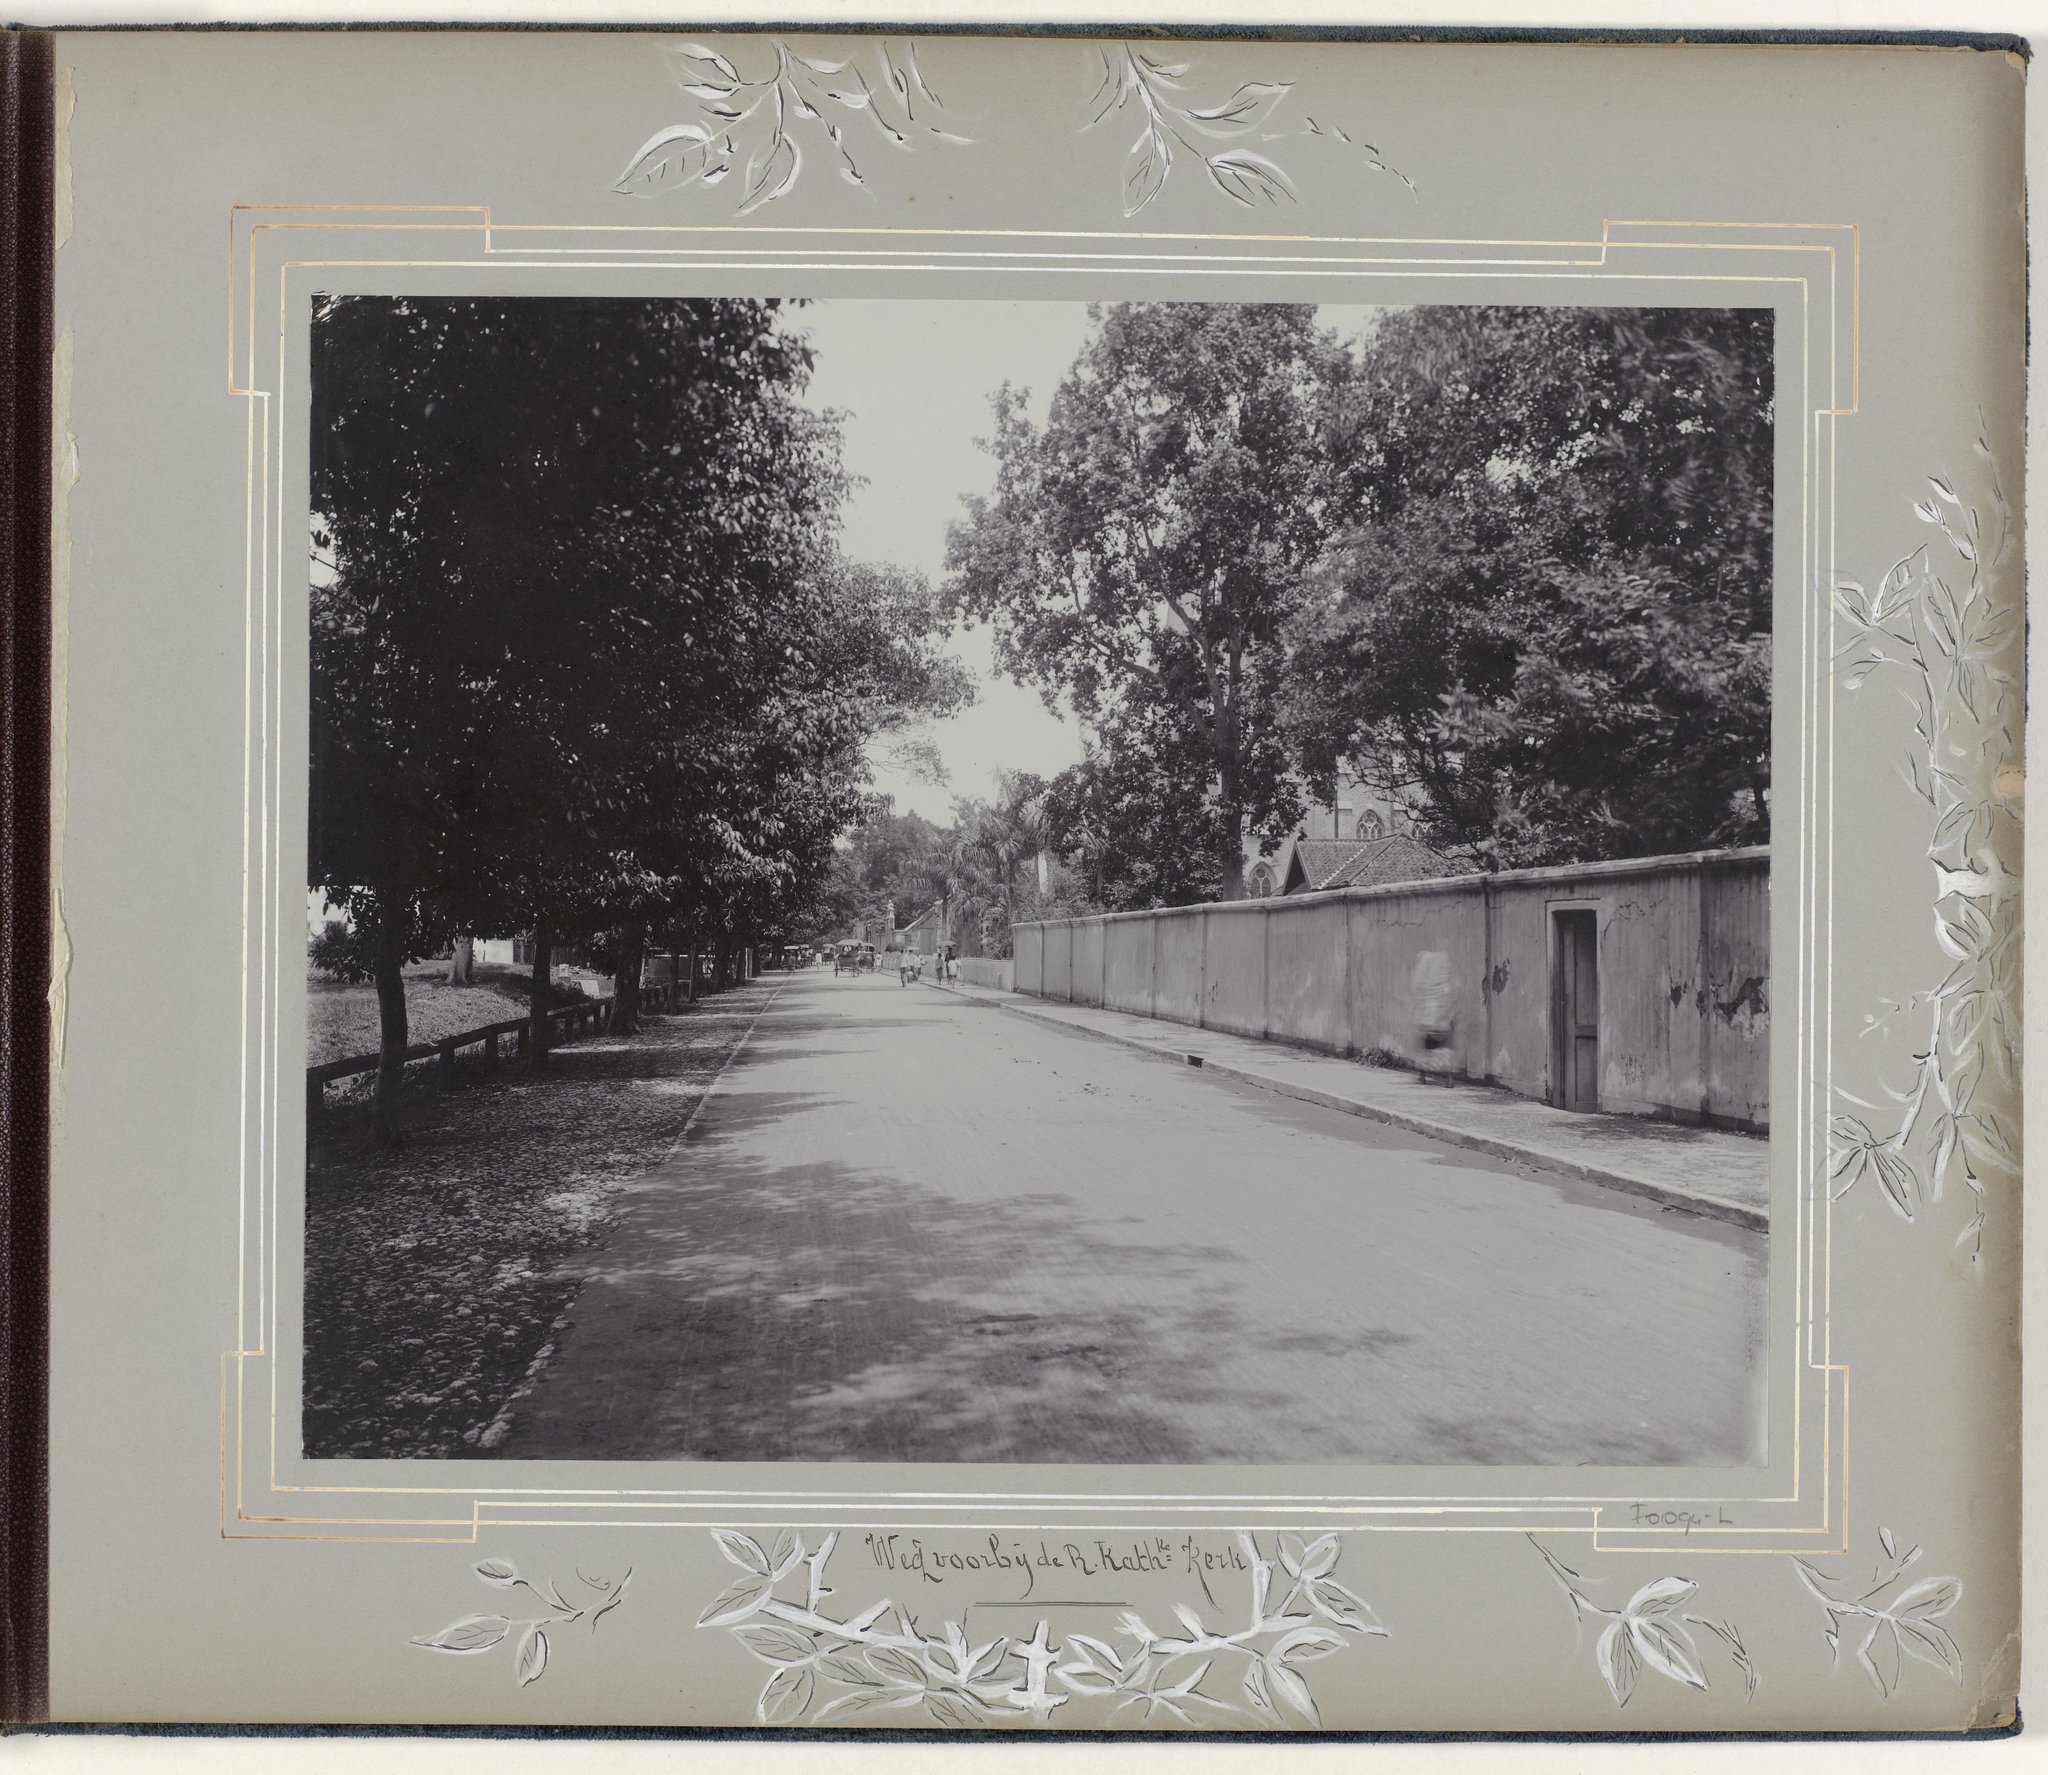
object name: album leaf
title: Weg langs de rooms-katholieke kerk van Soerabaja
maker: Anonymous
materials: cardboard, paper, photographic support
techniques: gelatin silver print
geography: surabaya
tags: fence, wall, paling, street, surabaya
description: Onderdeel van Herinneringsalbum met foto's van Soerabaja.